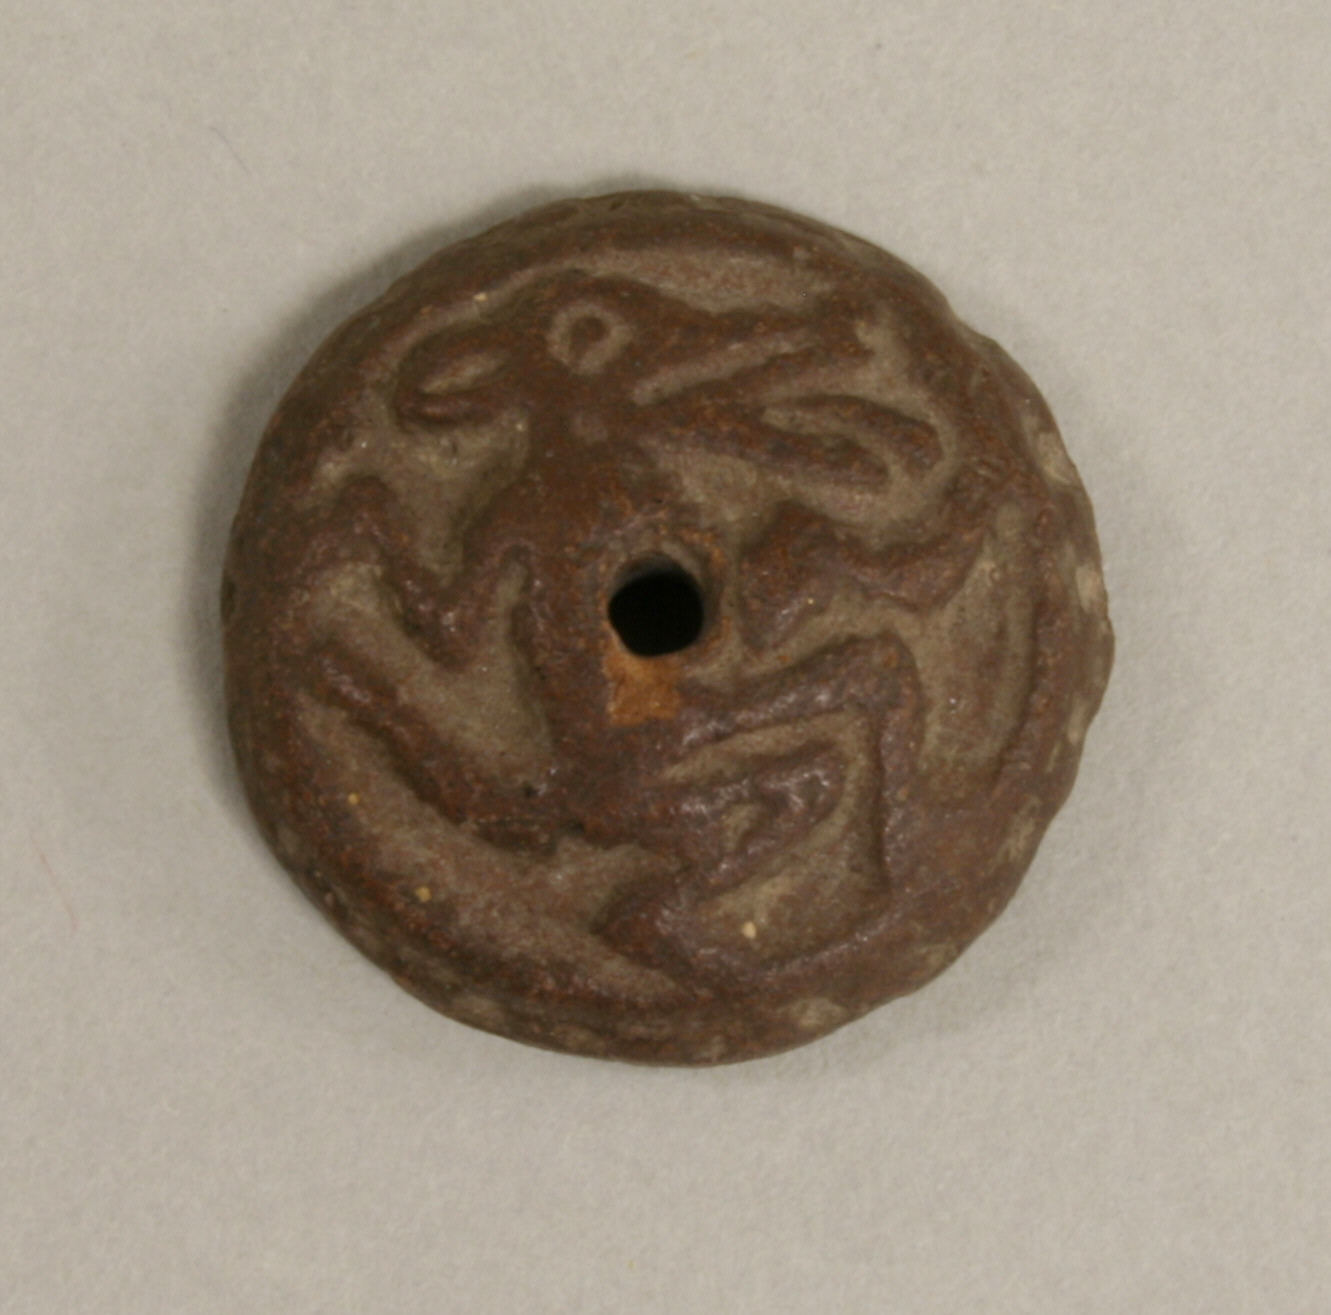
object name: spindle whorl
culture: mexican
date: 801-1500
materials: ceramic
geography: mexico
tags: animals